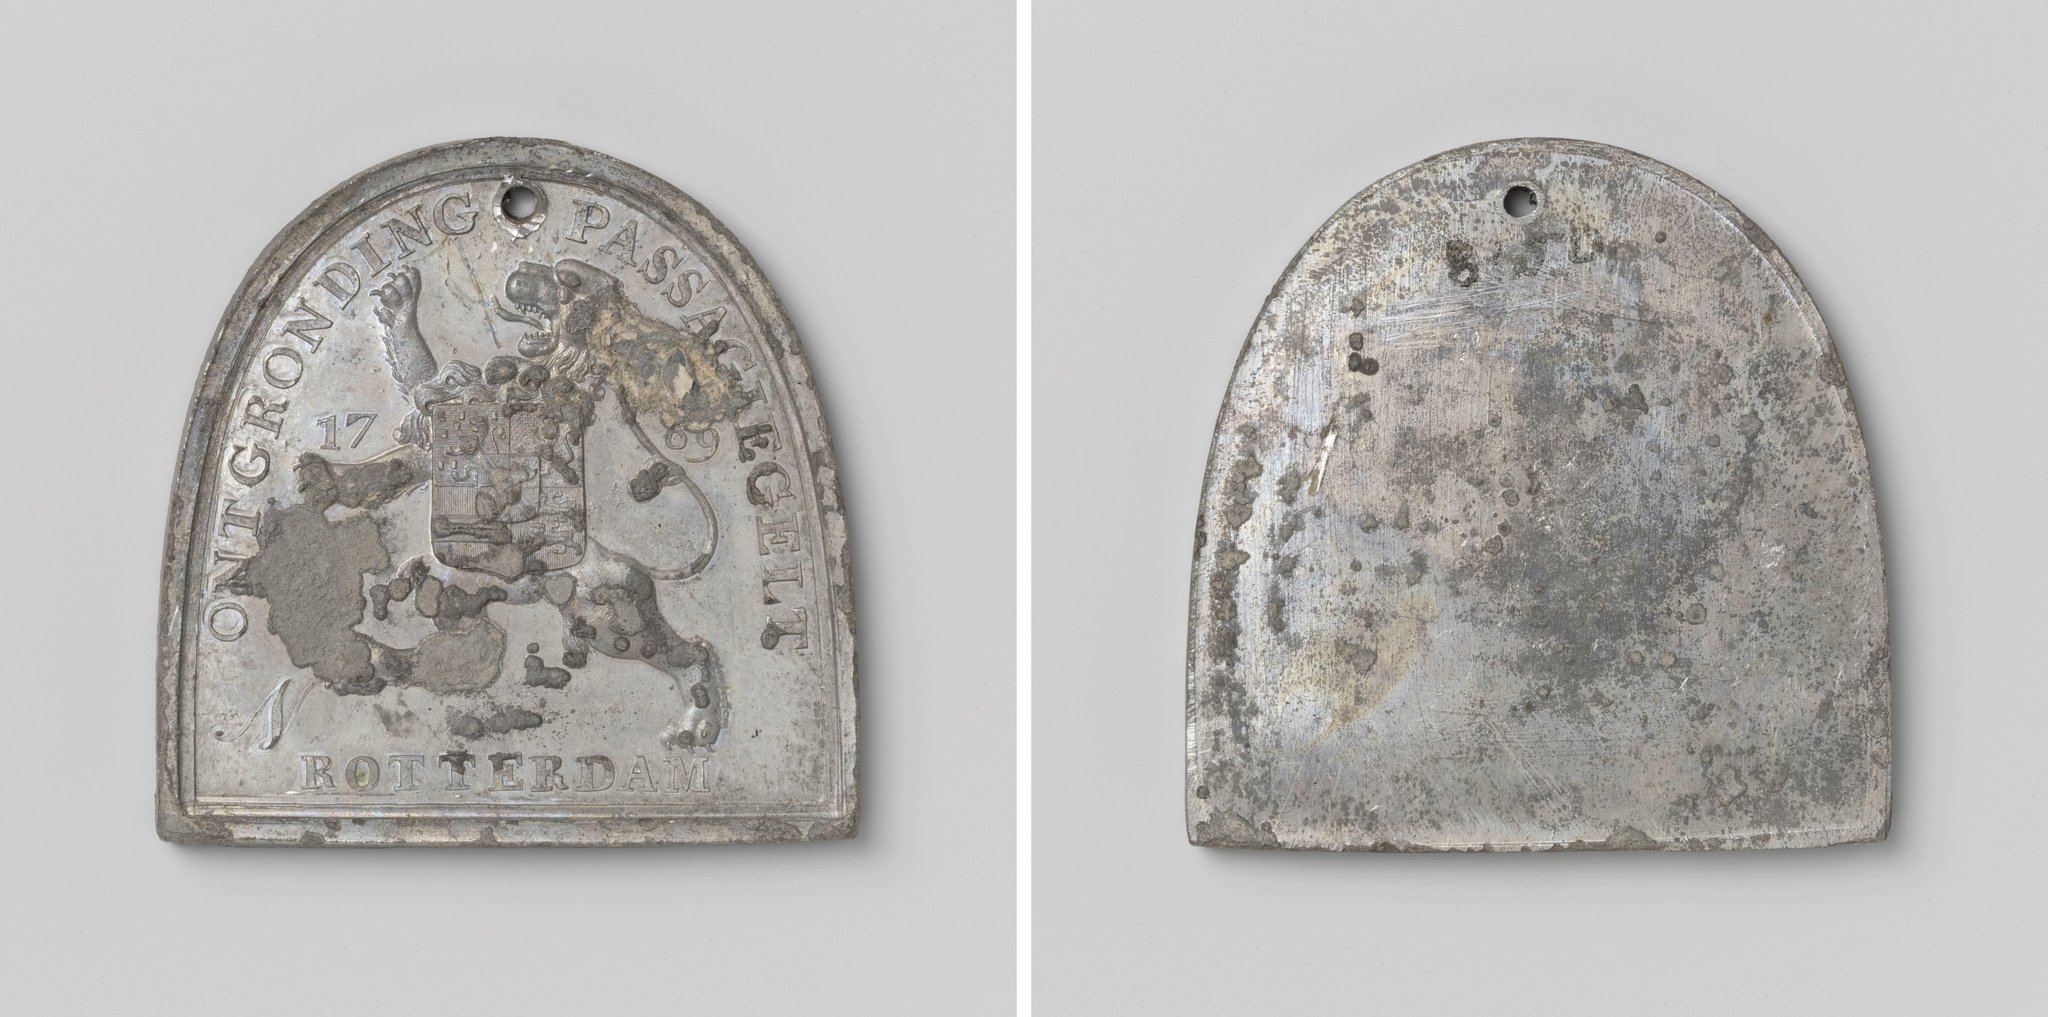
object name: identification medal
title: Ontgronding te Rotterdam, penning bedoeld als bewijs voor turfdragers, -vullers of -tonners om turf in te mogen voeren uit de nieuw ontgronde venen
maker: Anonymous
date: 1769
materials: lead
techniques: casting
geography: rotterdam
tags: rotterdam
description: Eenzijdige loden penning met ronde boven- en rechthoekige onderzijde, en gat erin. Voorzijde: staande leeuw met wapenschild op borst tussen jaartal binnen omschrift. Keerzijde: blanco.